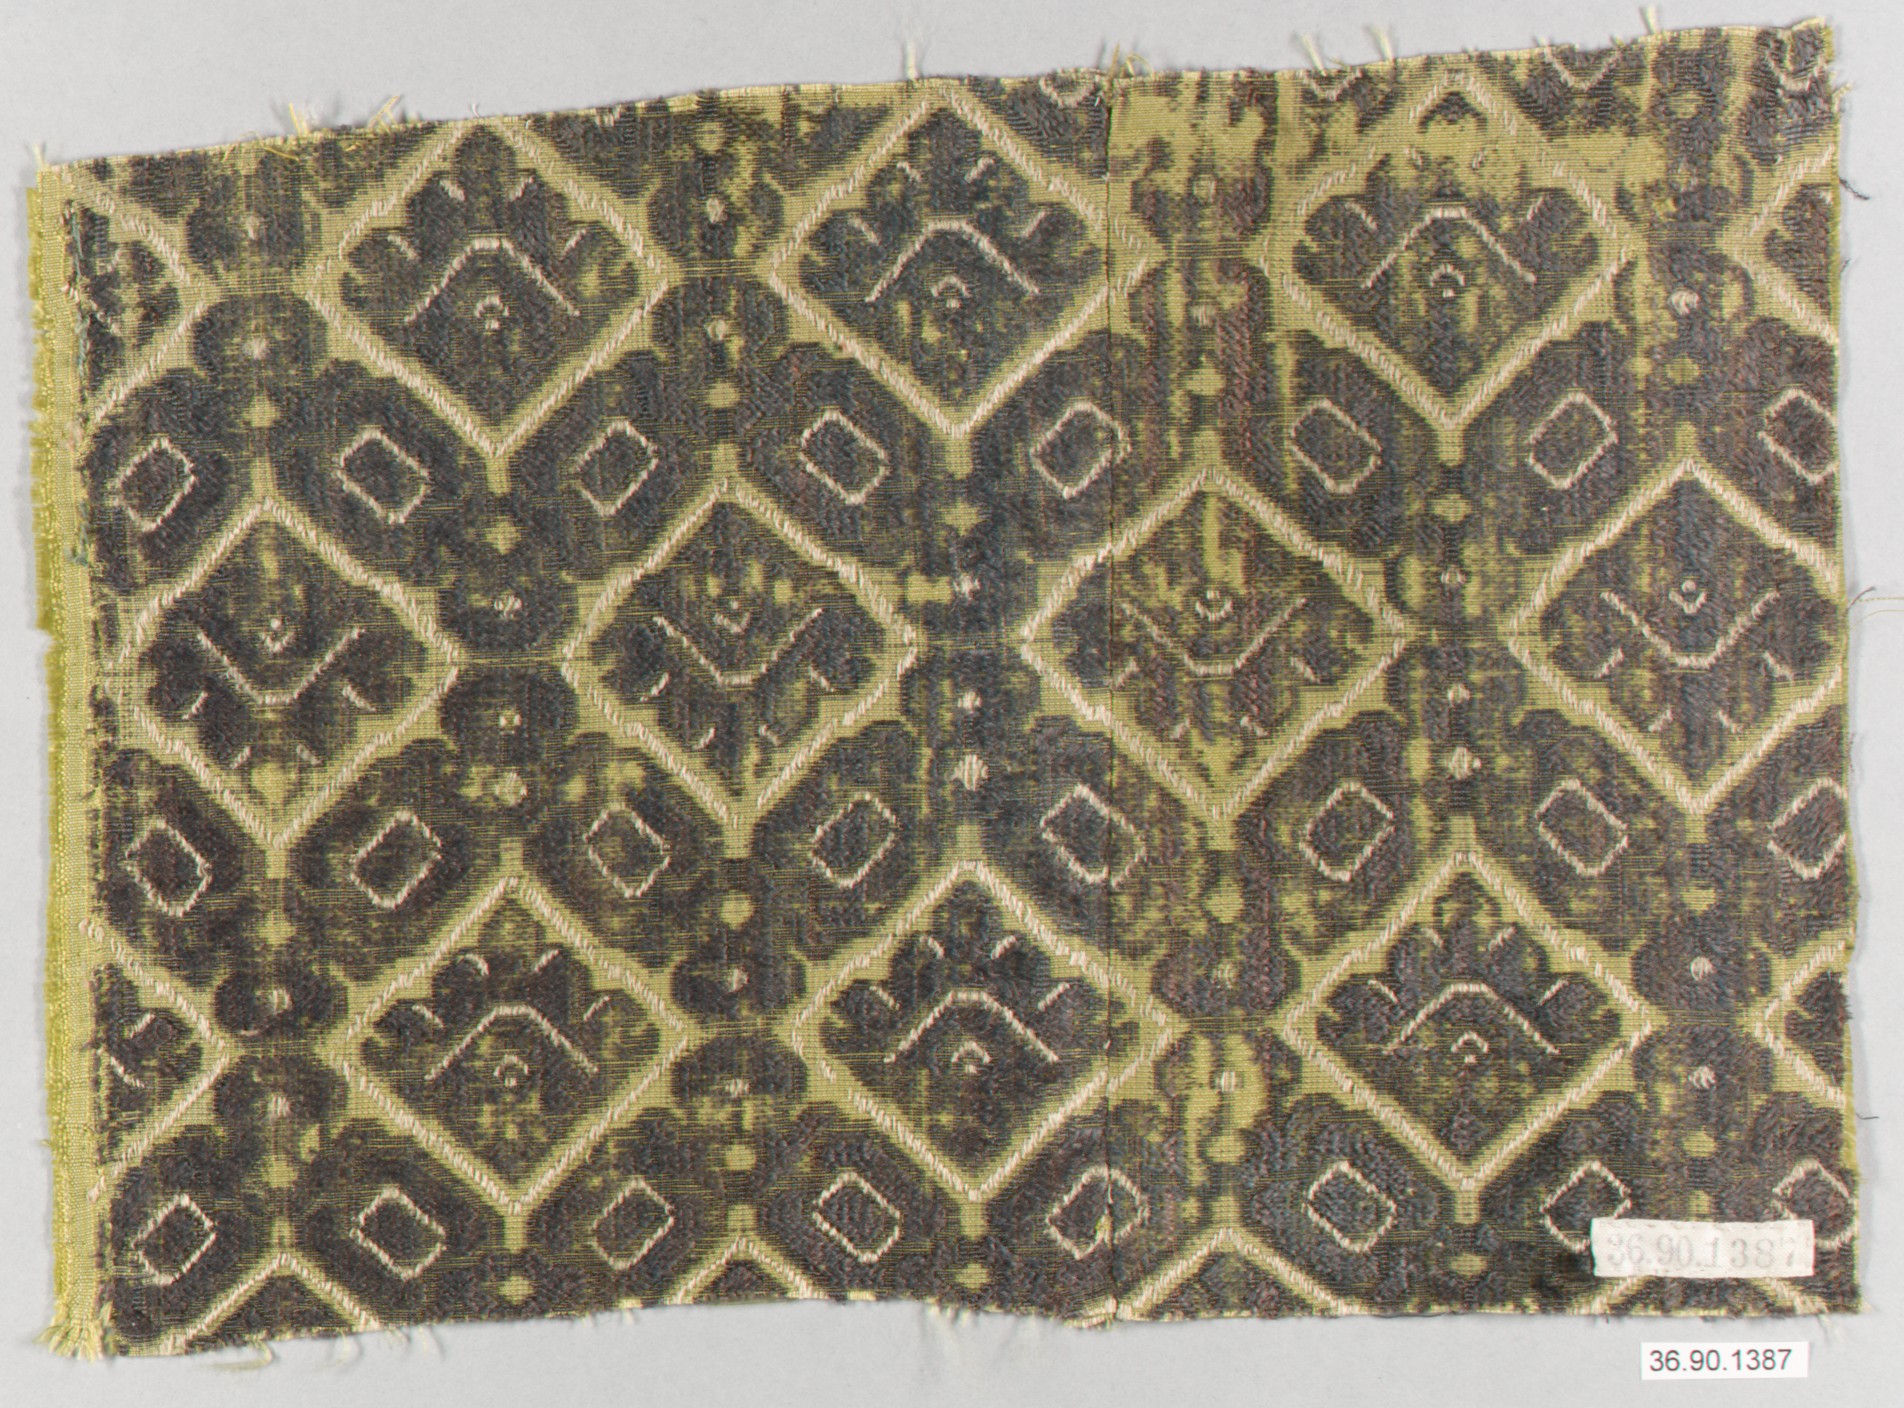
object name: piece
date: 1501-1600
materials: silk